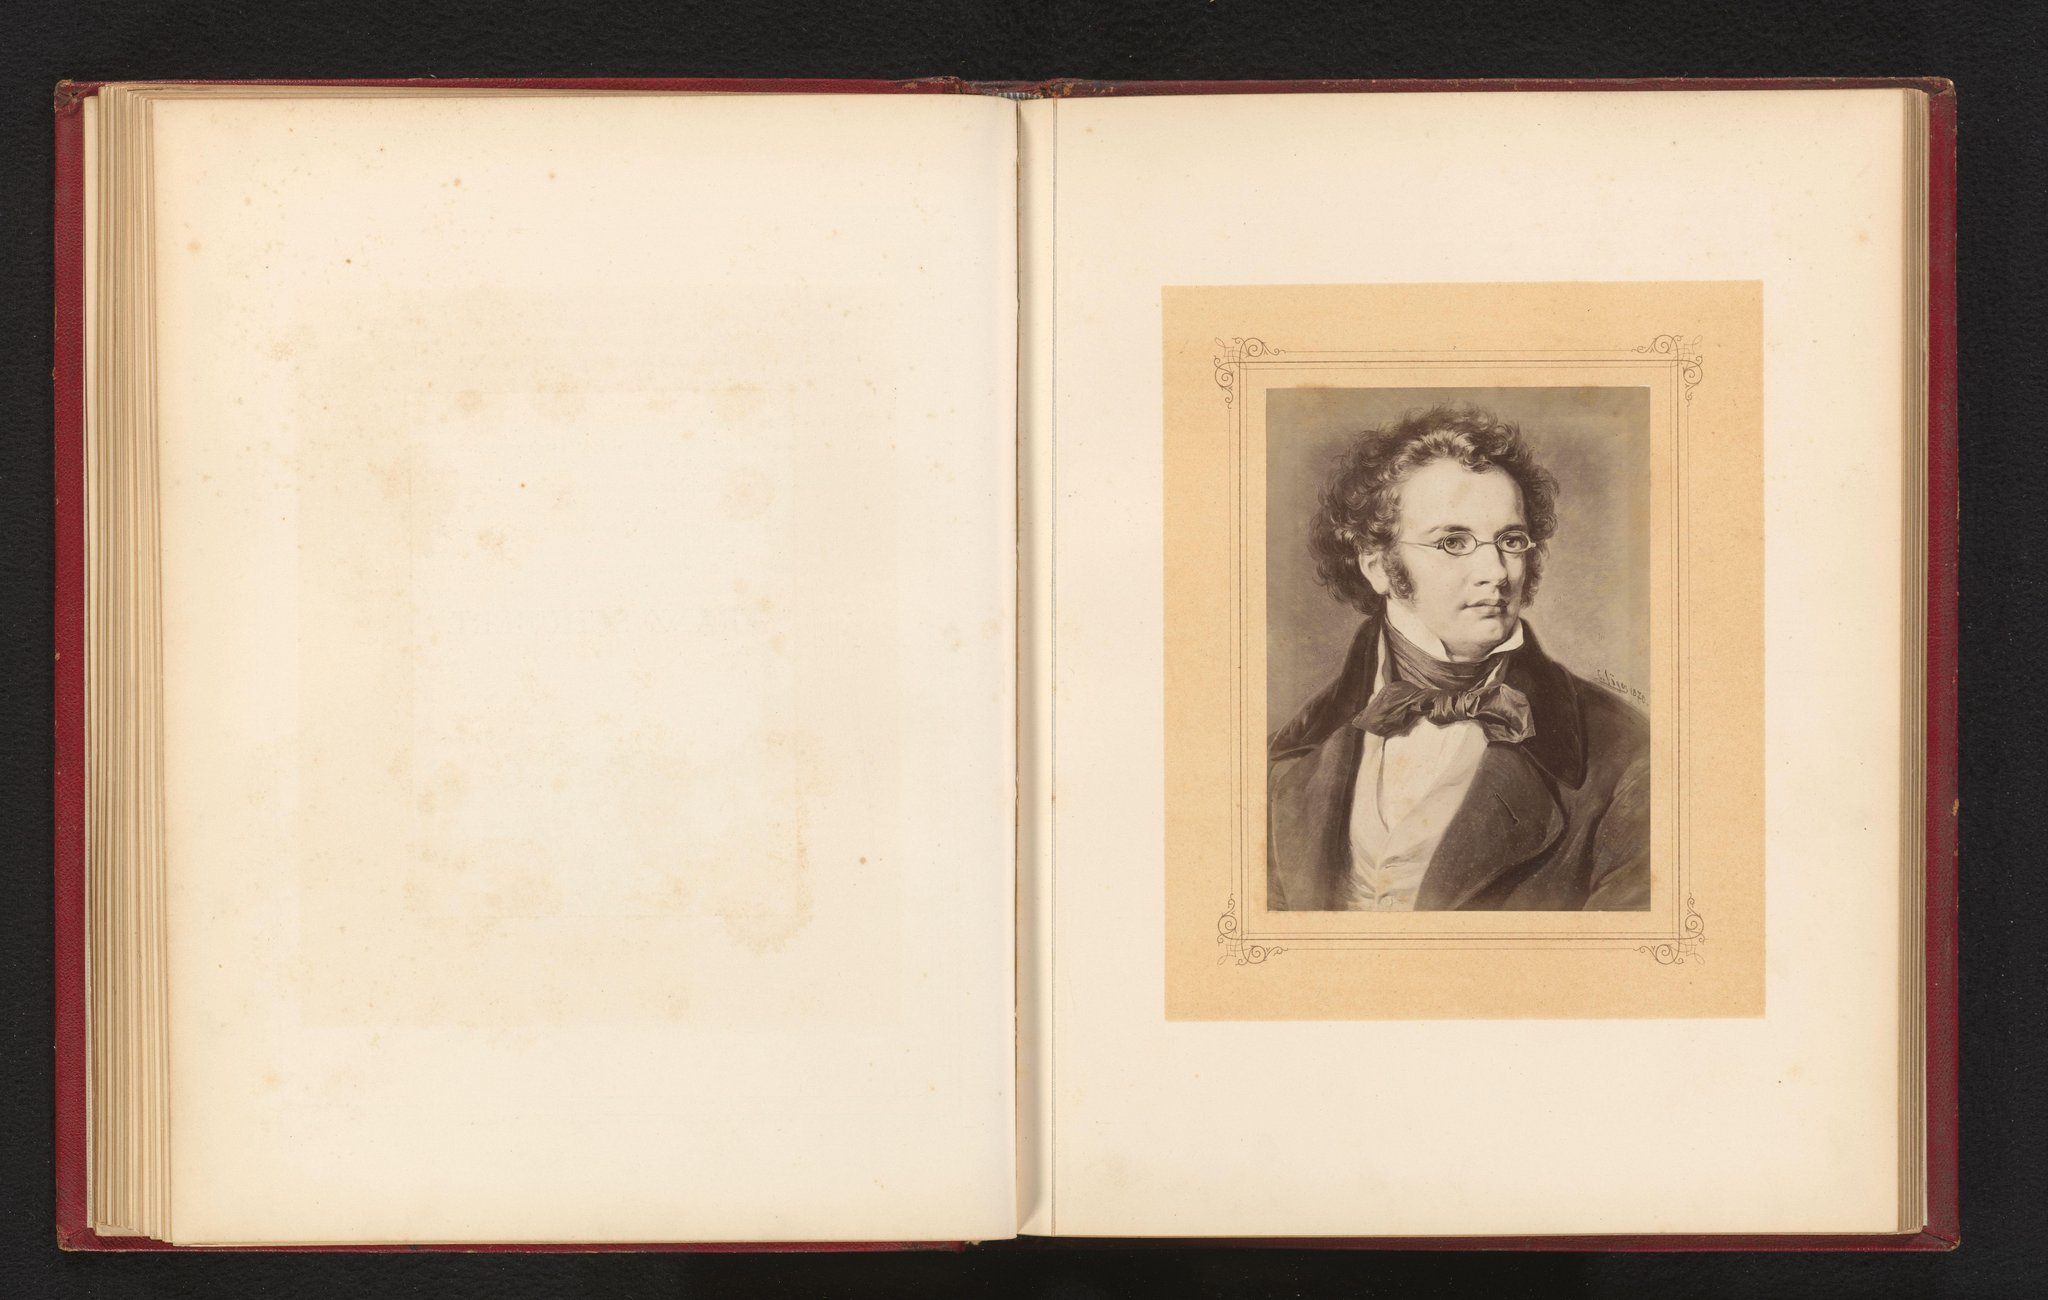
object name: reproduction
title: Fotoreproductie van een geschilderd portret van Franz Schubert door Carl Jaeger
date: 1870-1872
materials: paper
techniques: albumen print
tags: vienna, franz schubert, portrait of composer, picture, painting